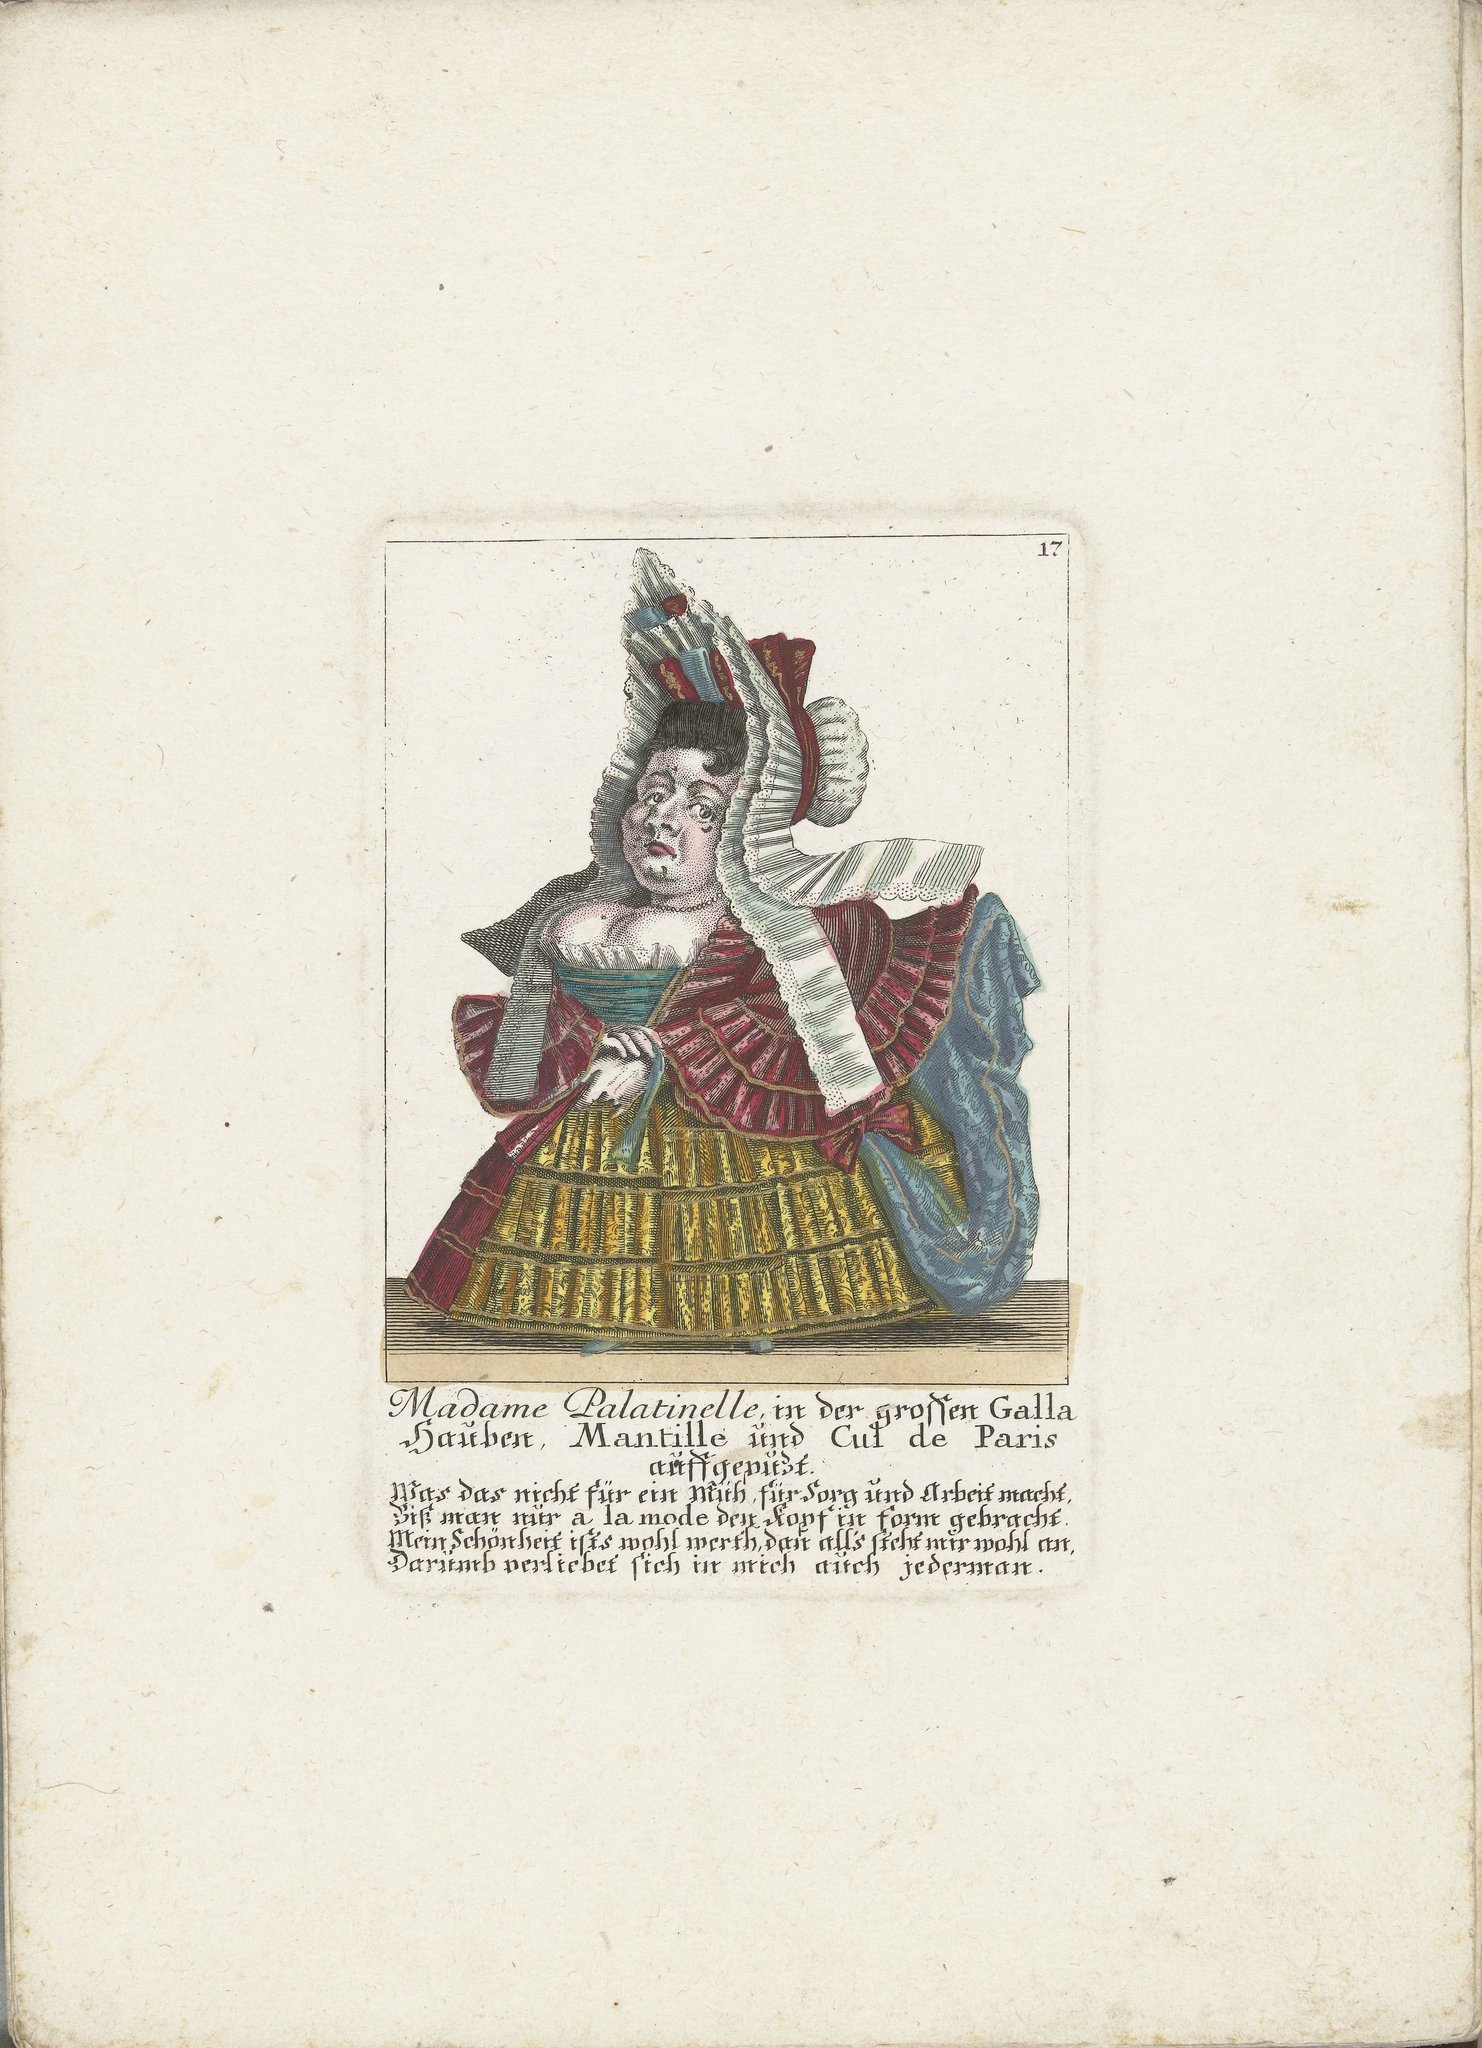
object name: print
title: De Franse kleine mens Madame Palatinelle, ca. 1710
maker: martin engelbrecht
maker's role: print maker, publisher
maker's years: 1684-1756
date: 1705-1715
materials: paper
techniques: engraving, etching, hand coloring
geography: augsburg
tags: caricatures (human types), little people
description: De Franse kleine mens Madame Palatinelle, in gala. In het onderschrift onder de titel een vierregelig vers in het Duits. Genummerd rechtsboven: 17. Onderdeel van een losbladige uitgave uit ca. 1710 van een serie karikaturen van kleine mensen, bekend als Het Dwergentooneel.